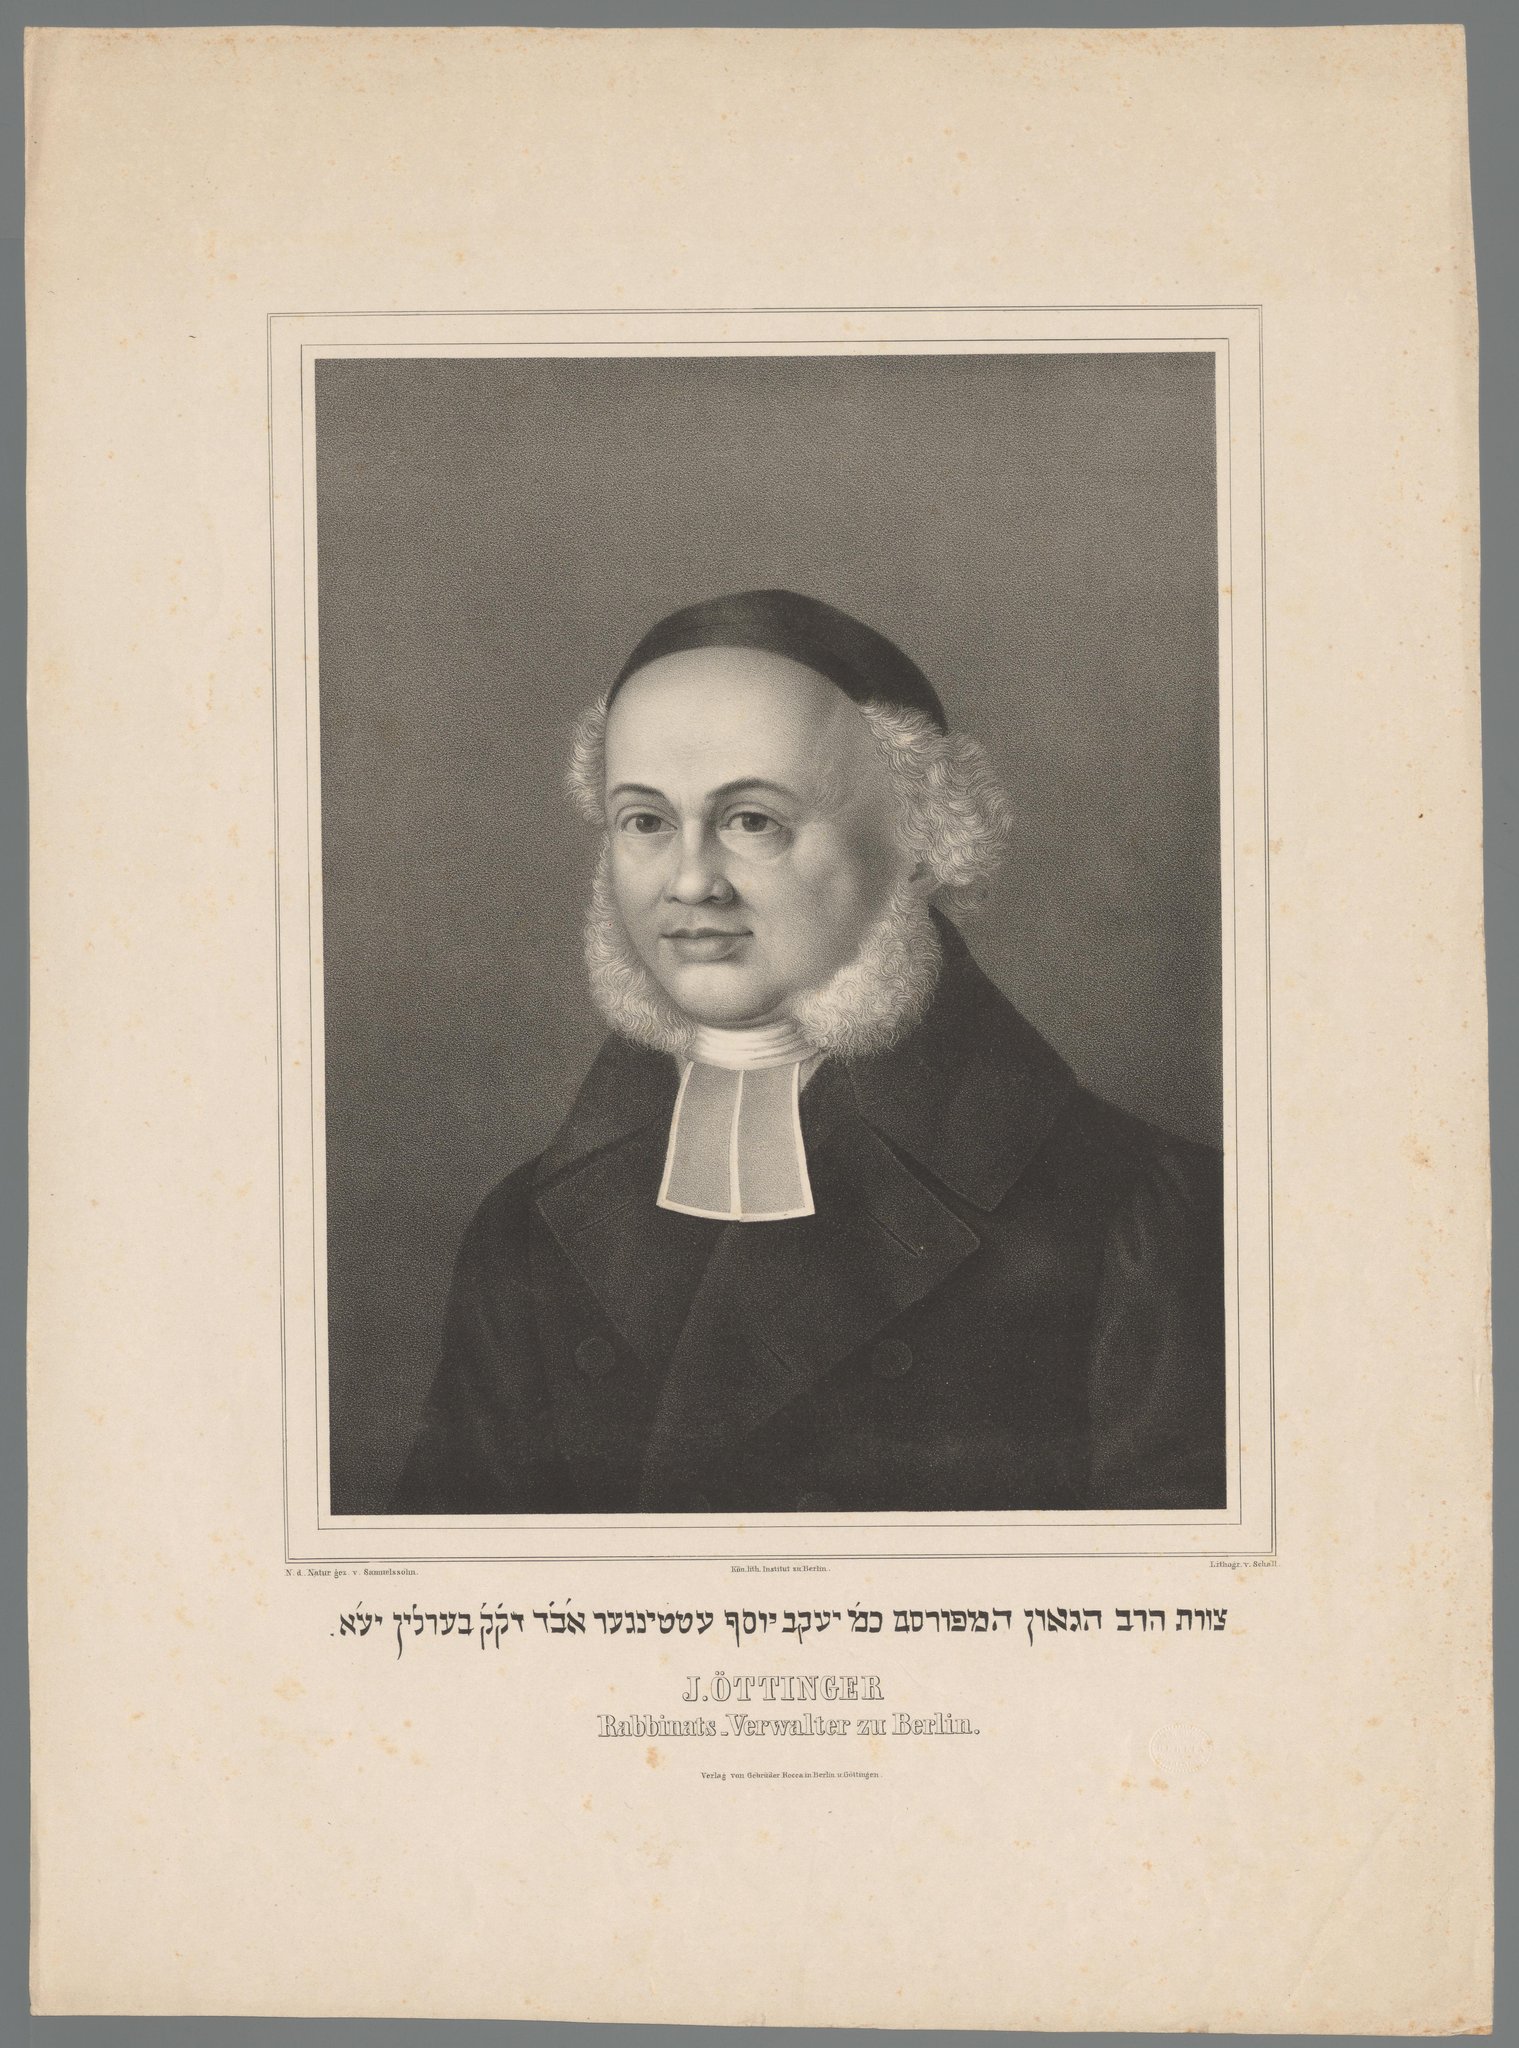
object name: print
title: Portret van Jacob Joseph Oettinger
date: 1830-1865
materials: paper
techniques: lithograph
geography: berlin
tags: head-gear, adult man, historical persons, rabbi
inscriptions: collector's mark: Lugt 2228, check stamp: Lugt 4607